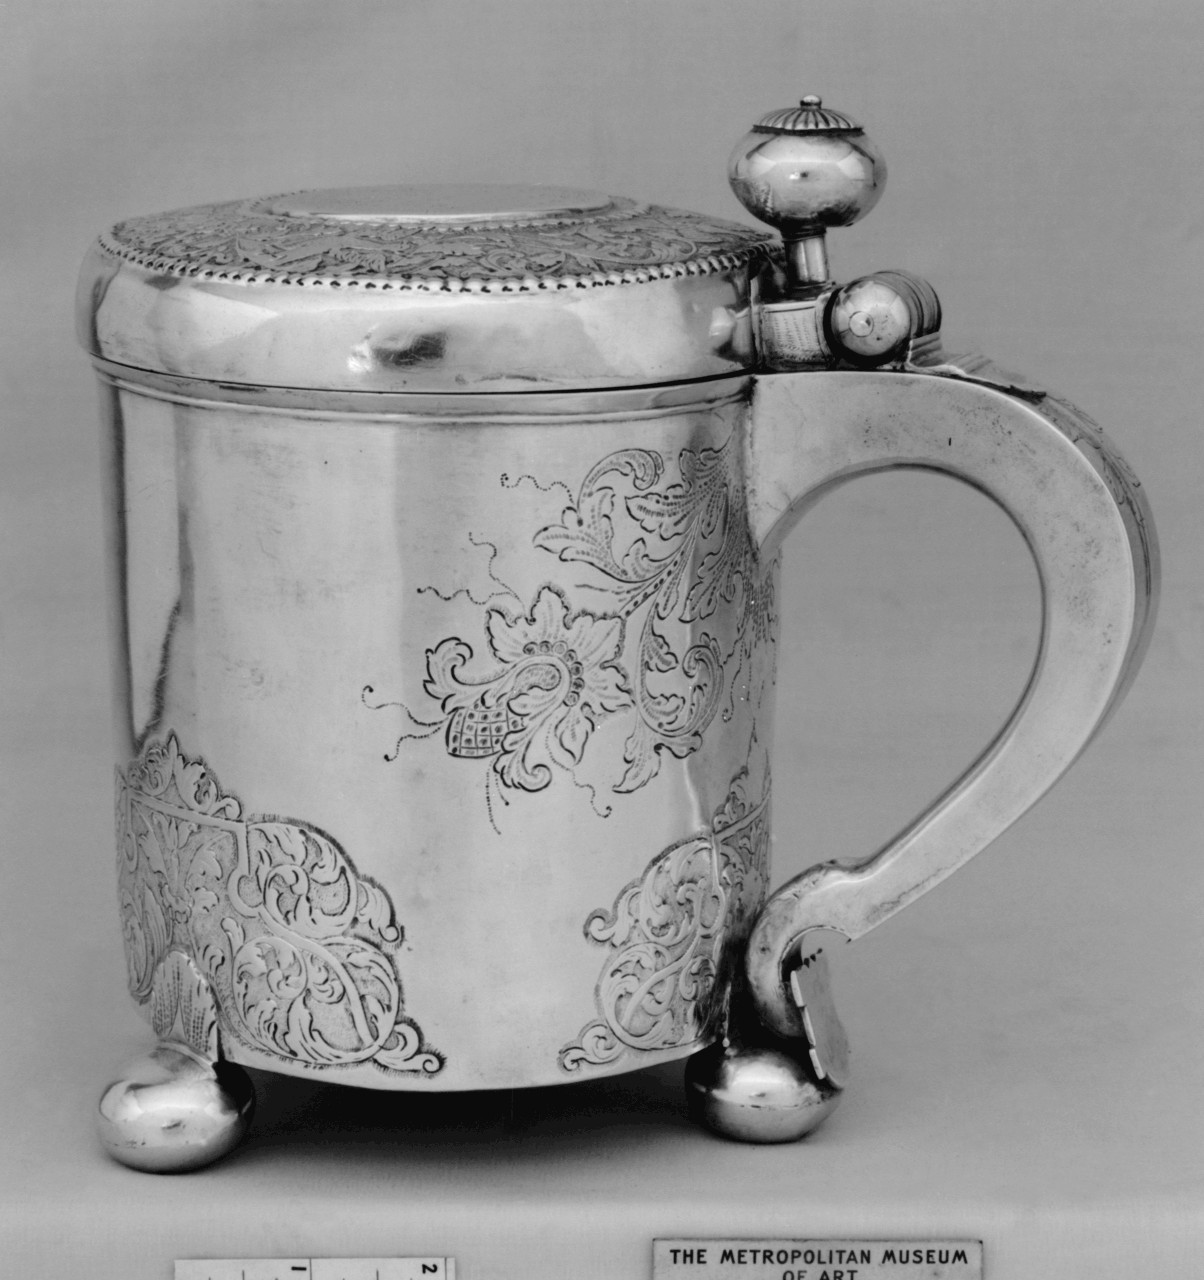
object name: peg tankard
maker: andreas lude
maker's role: maker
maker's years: 1776-1796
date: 1780-1782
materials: silver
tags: flowers